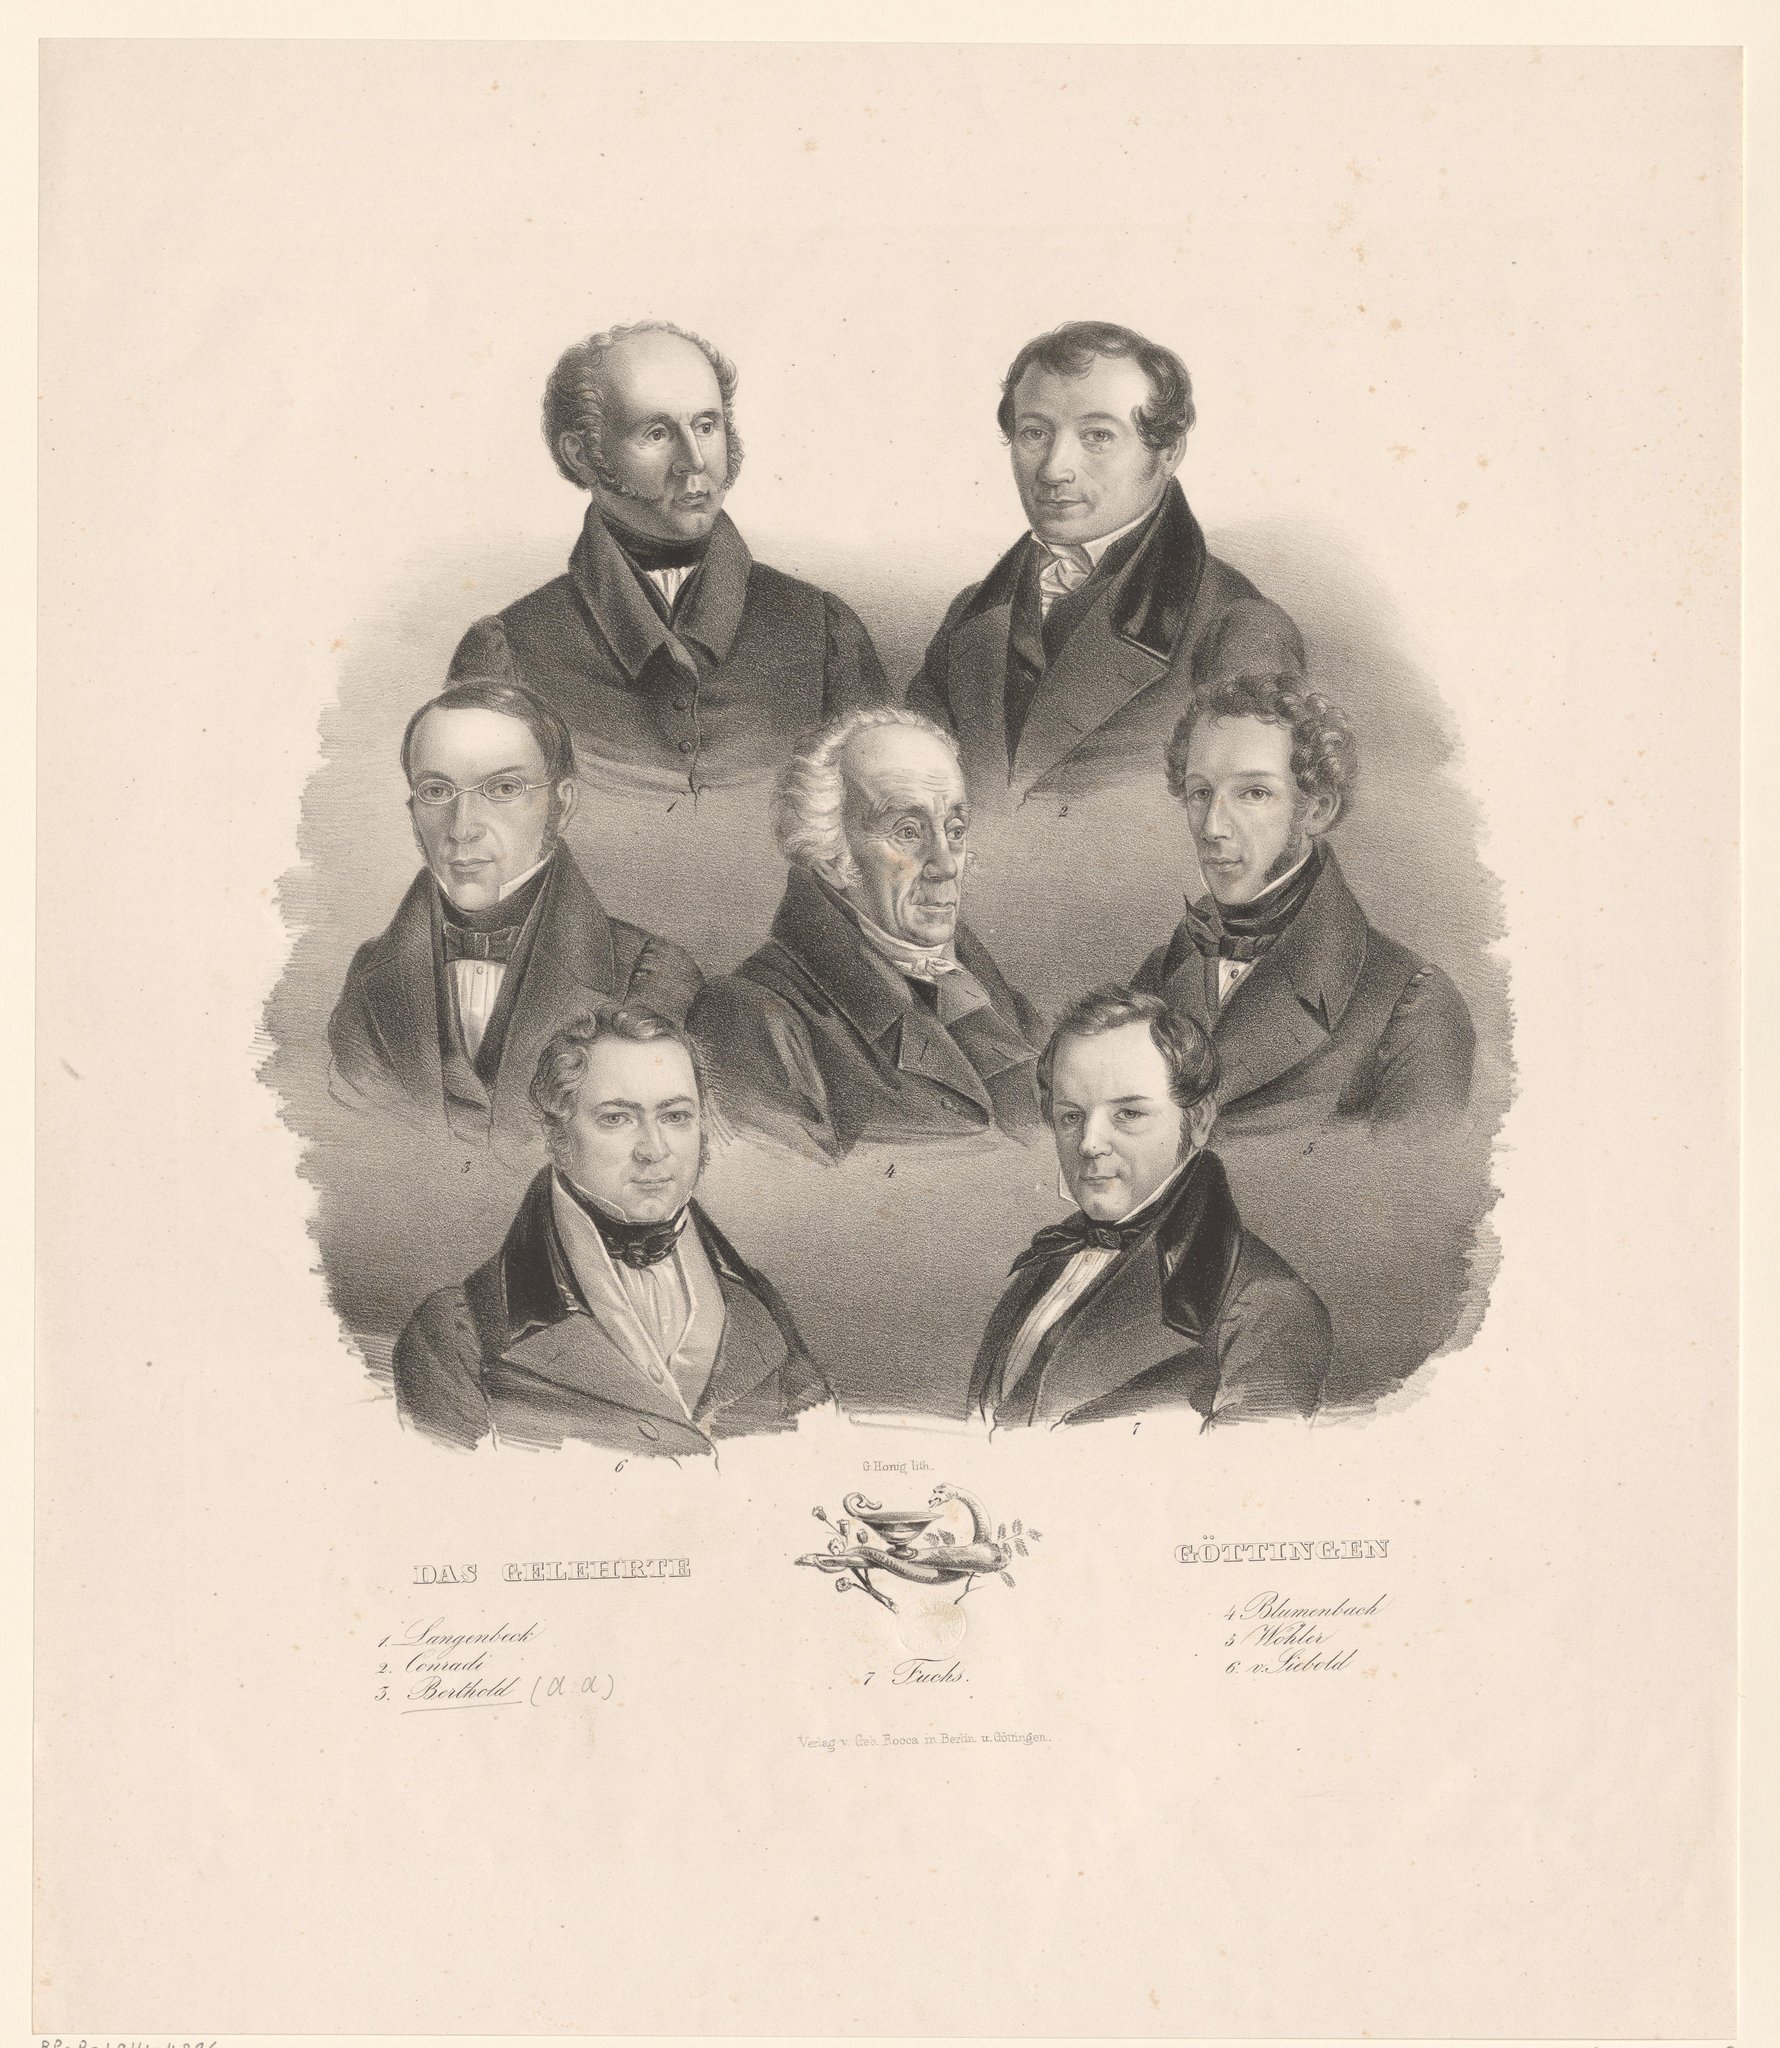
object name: print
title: Portretten van zeven geleerden uit Göttingen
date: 1830-1863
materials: paper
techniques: lithograph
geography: gottingen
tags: scholar, philosopher, historical persons, anonymous historical persons portrayed in a group, in a group-portrait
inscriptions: workshop stamp: ‘Gebruder Rocca in Gottingen’, collector's mark: Lugt 2228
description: Portretten van Conrad Johann Martin Langenbeck, Johann Wilhelm Heinrich Conradi, Arnold Adolph Berthold, Johann Friedrich Blumenbach, Friedrich Wöhler, Eduard Caspar Jacob von Siebold en Conrad Heinrich Fuchs.